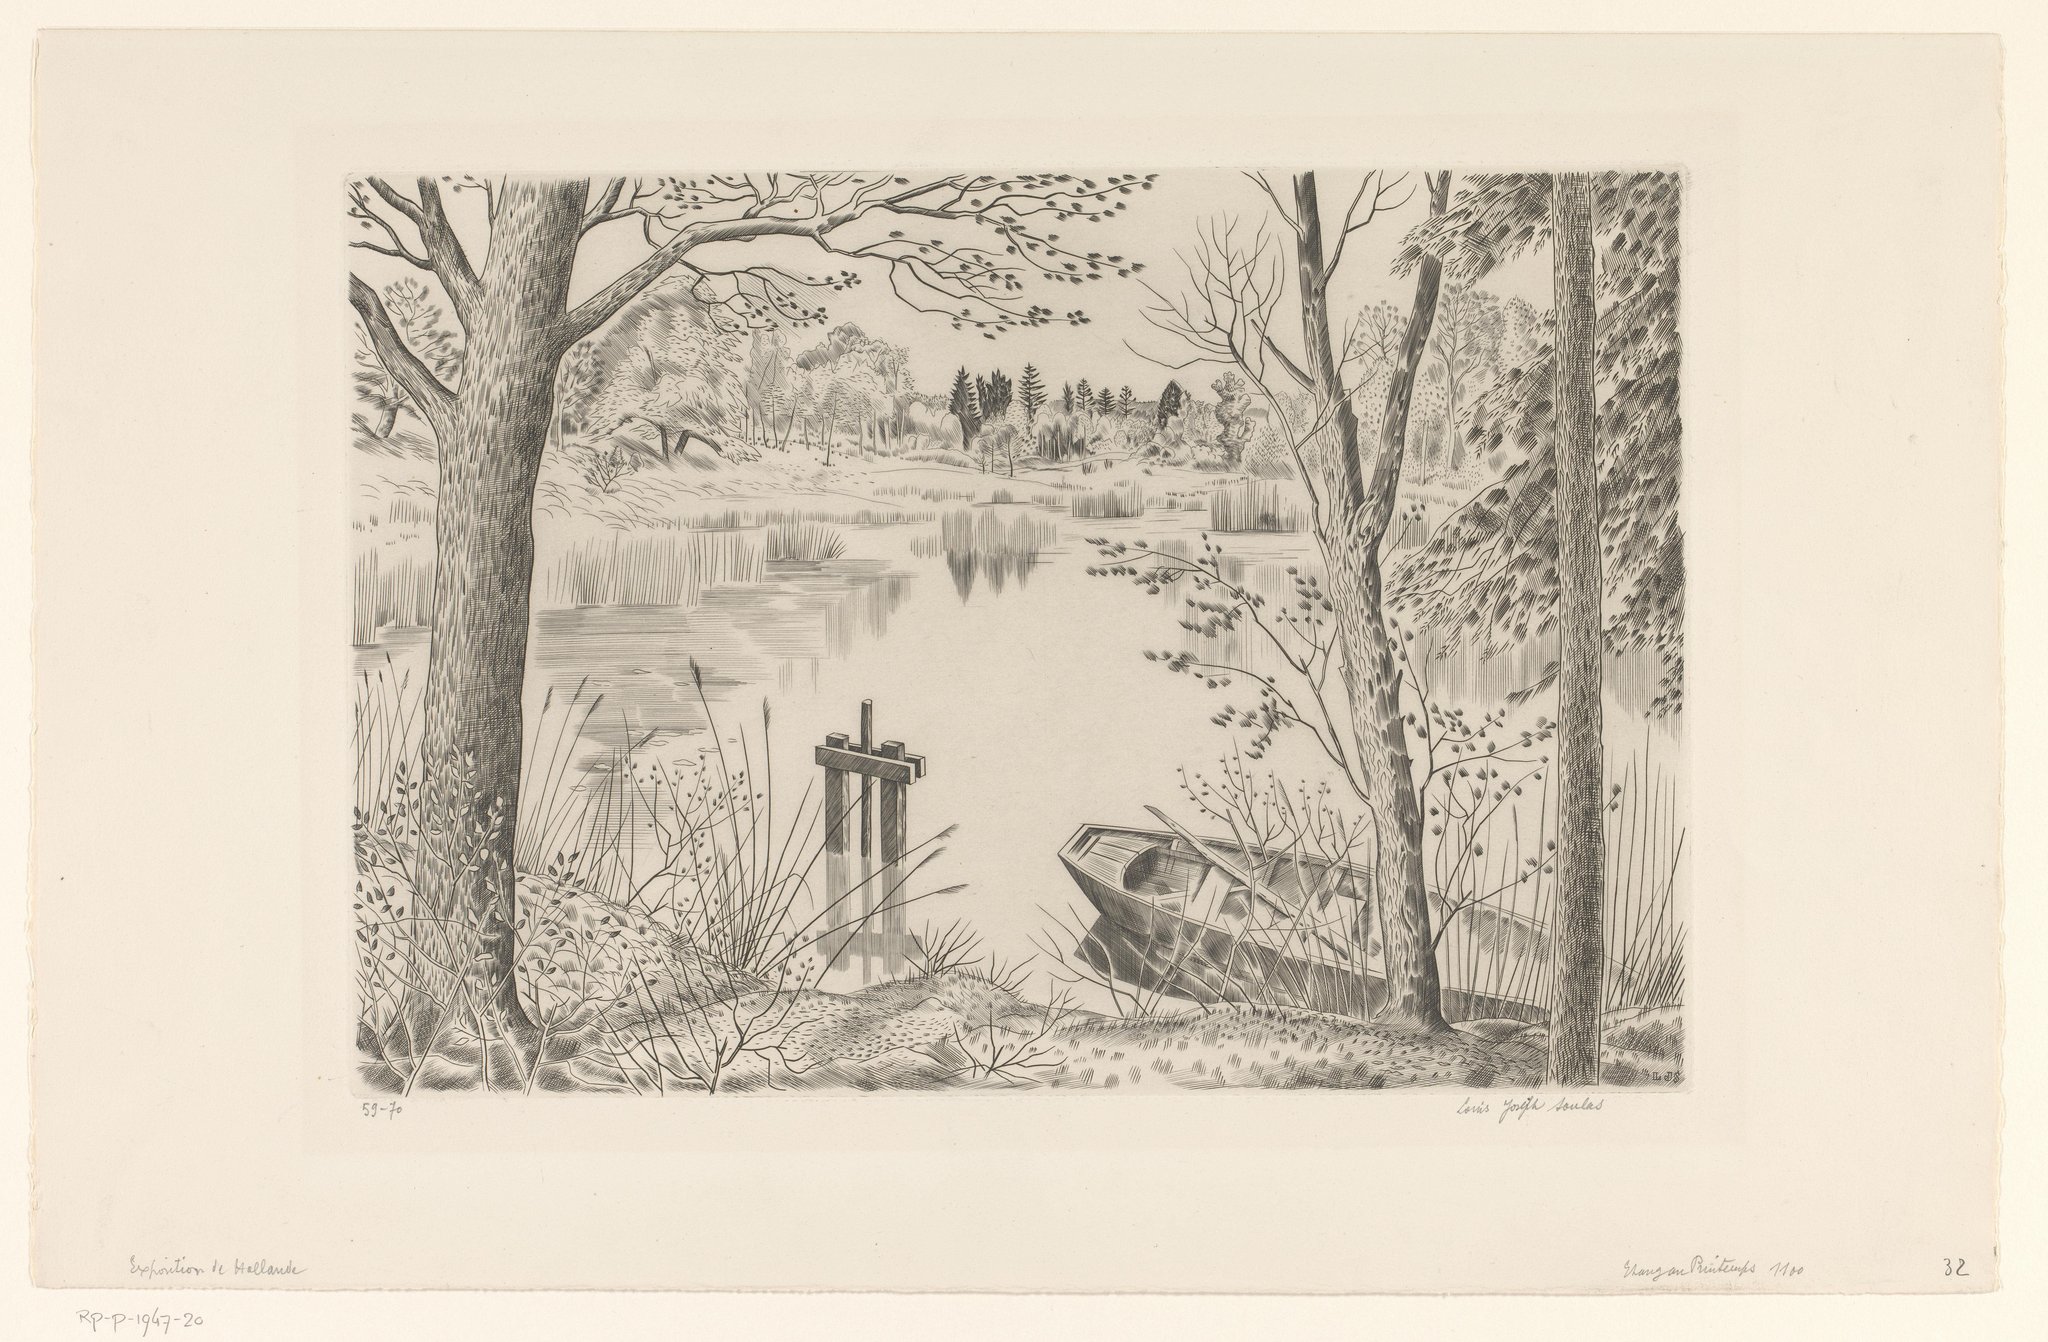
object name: print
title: Etang au printemps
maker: louis joseph soulas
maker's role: print maker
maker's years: 1905-1954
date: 1925-1947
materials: paper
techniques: engraving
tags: pond, pool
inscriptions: annotation: ‘Exposition de Hollande/ Etang au Printemps 1100/ 32’, watermark: ‘B F K RIVES’, collector's mark: Lugt 2228